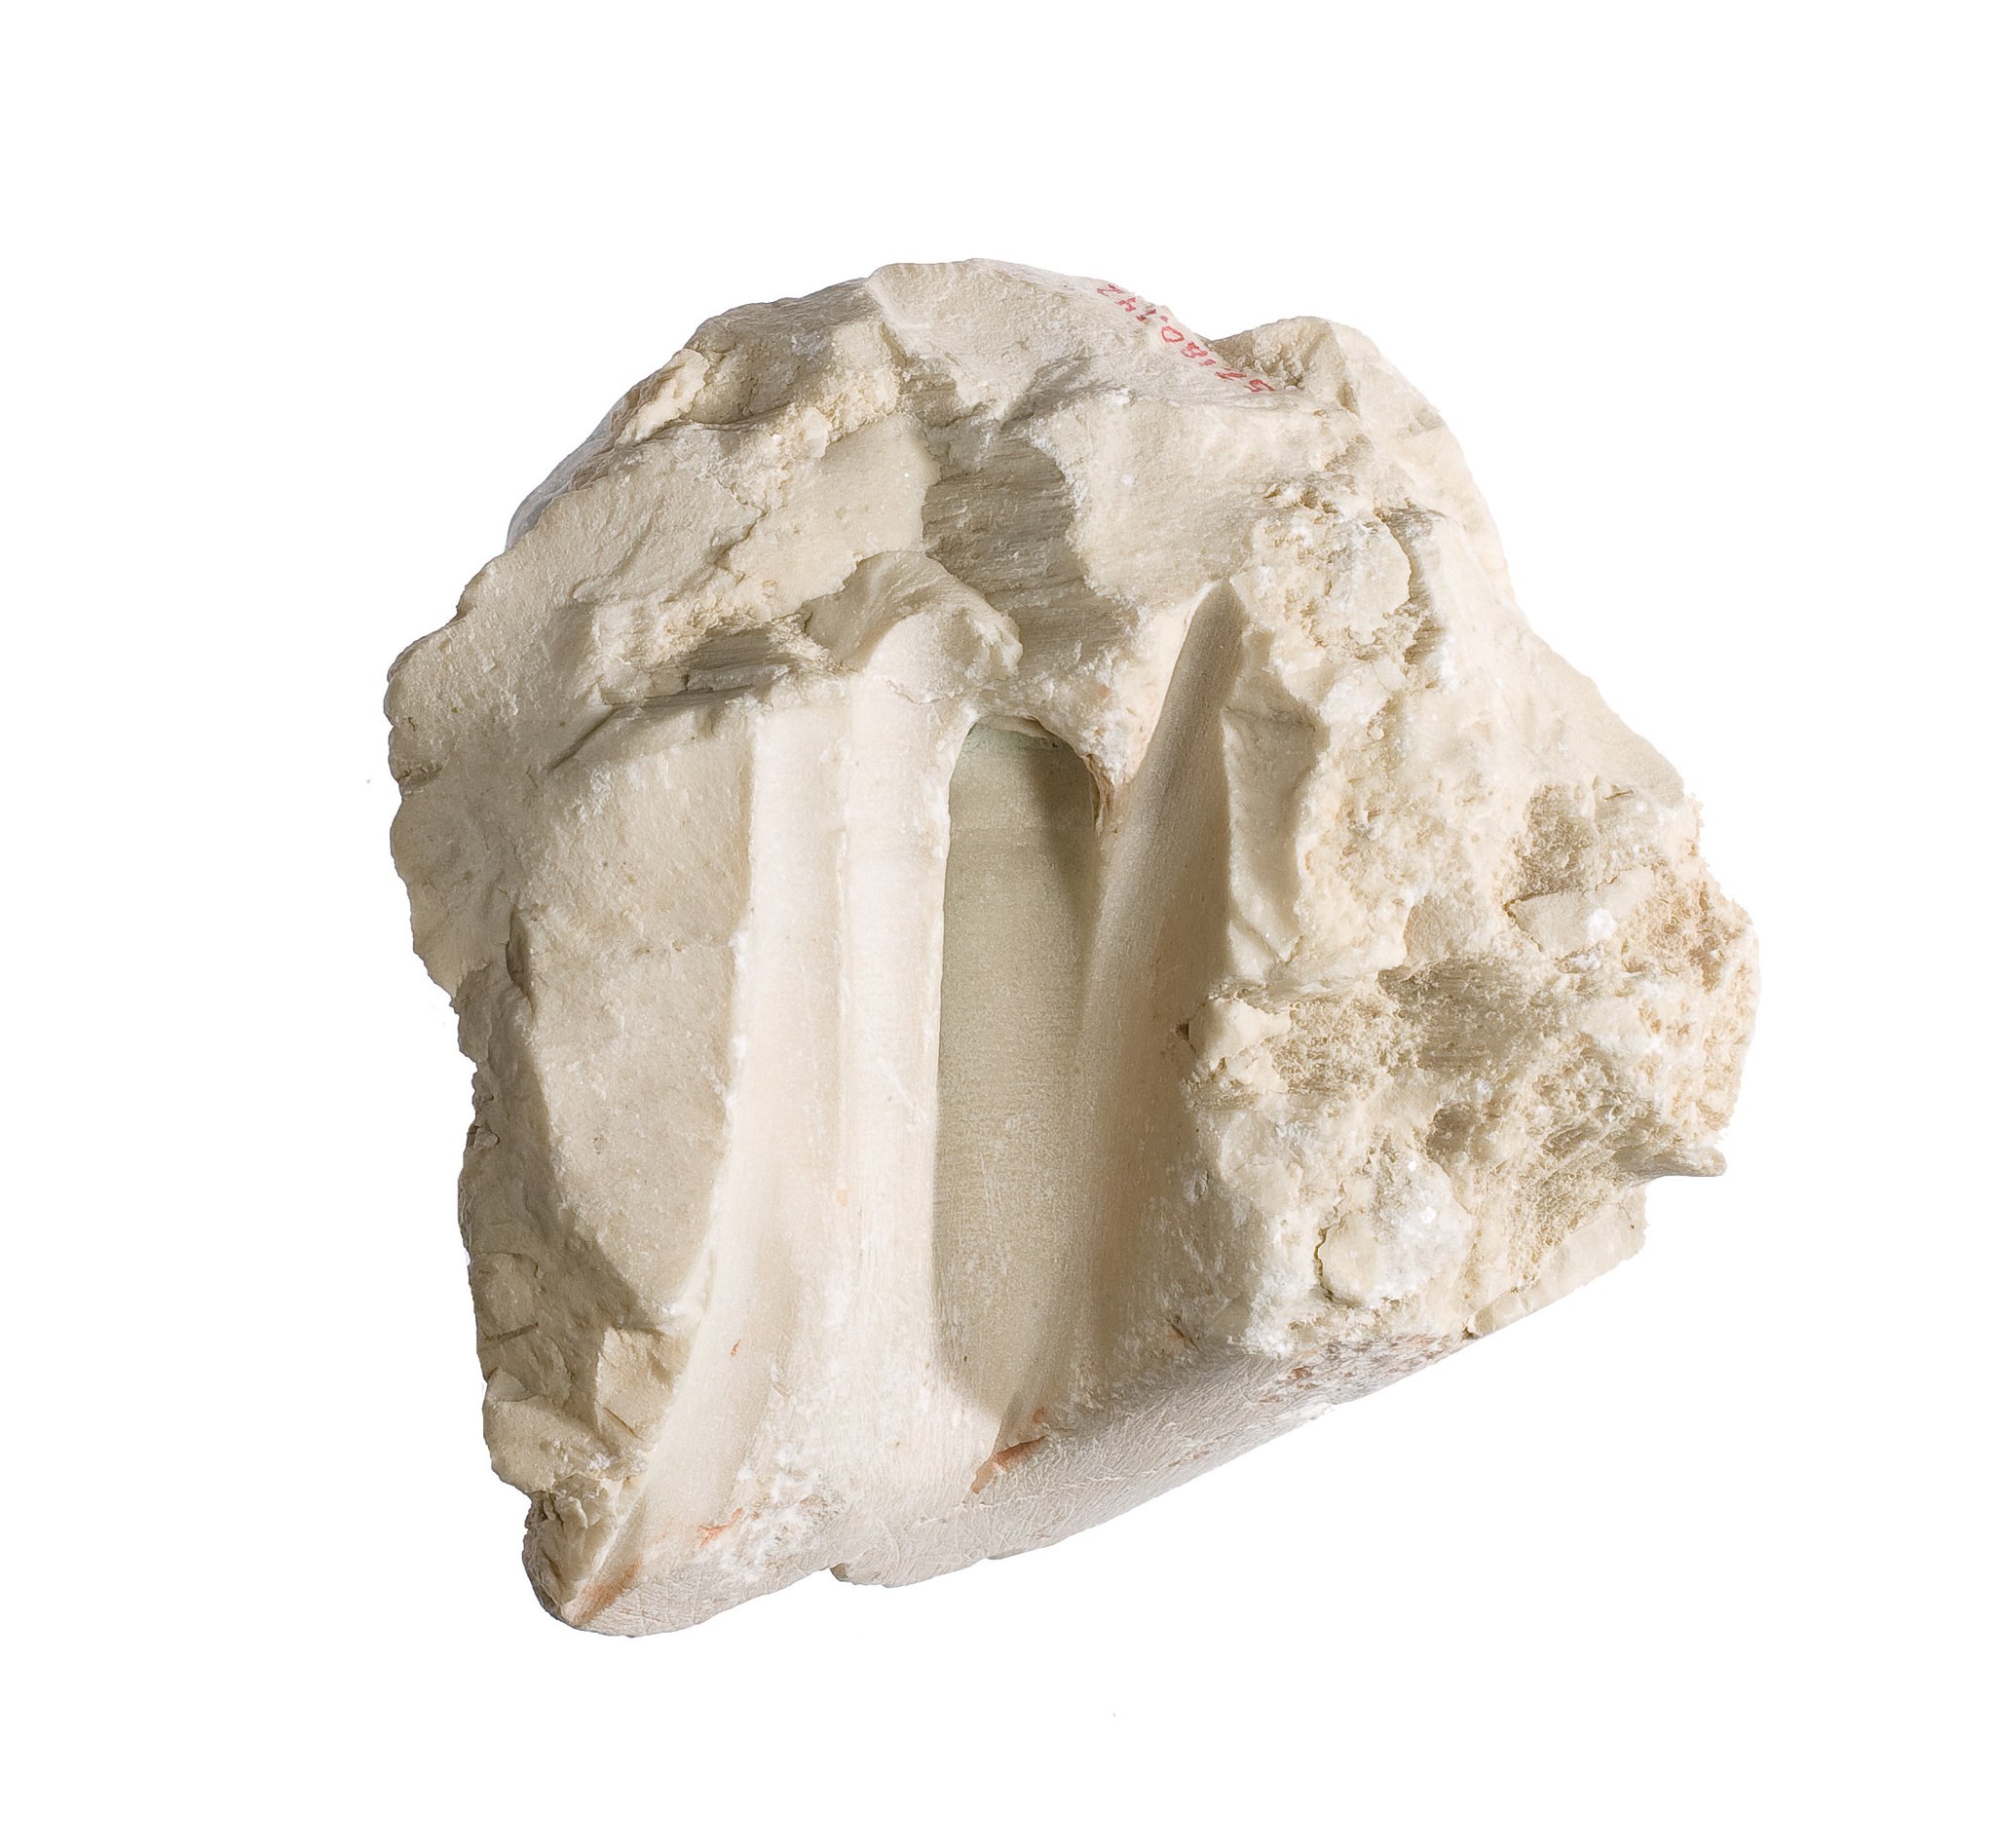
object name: fragment with working trace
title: Fragment with working traces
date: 1353-1336 BCE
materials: limestone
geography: egypt